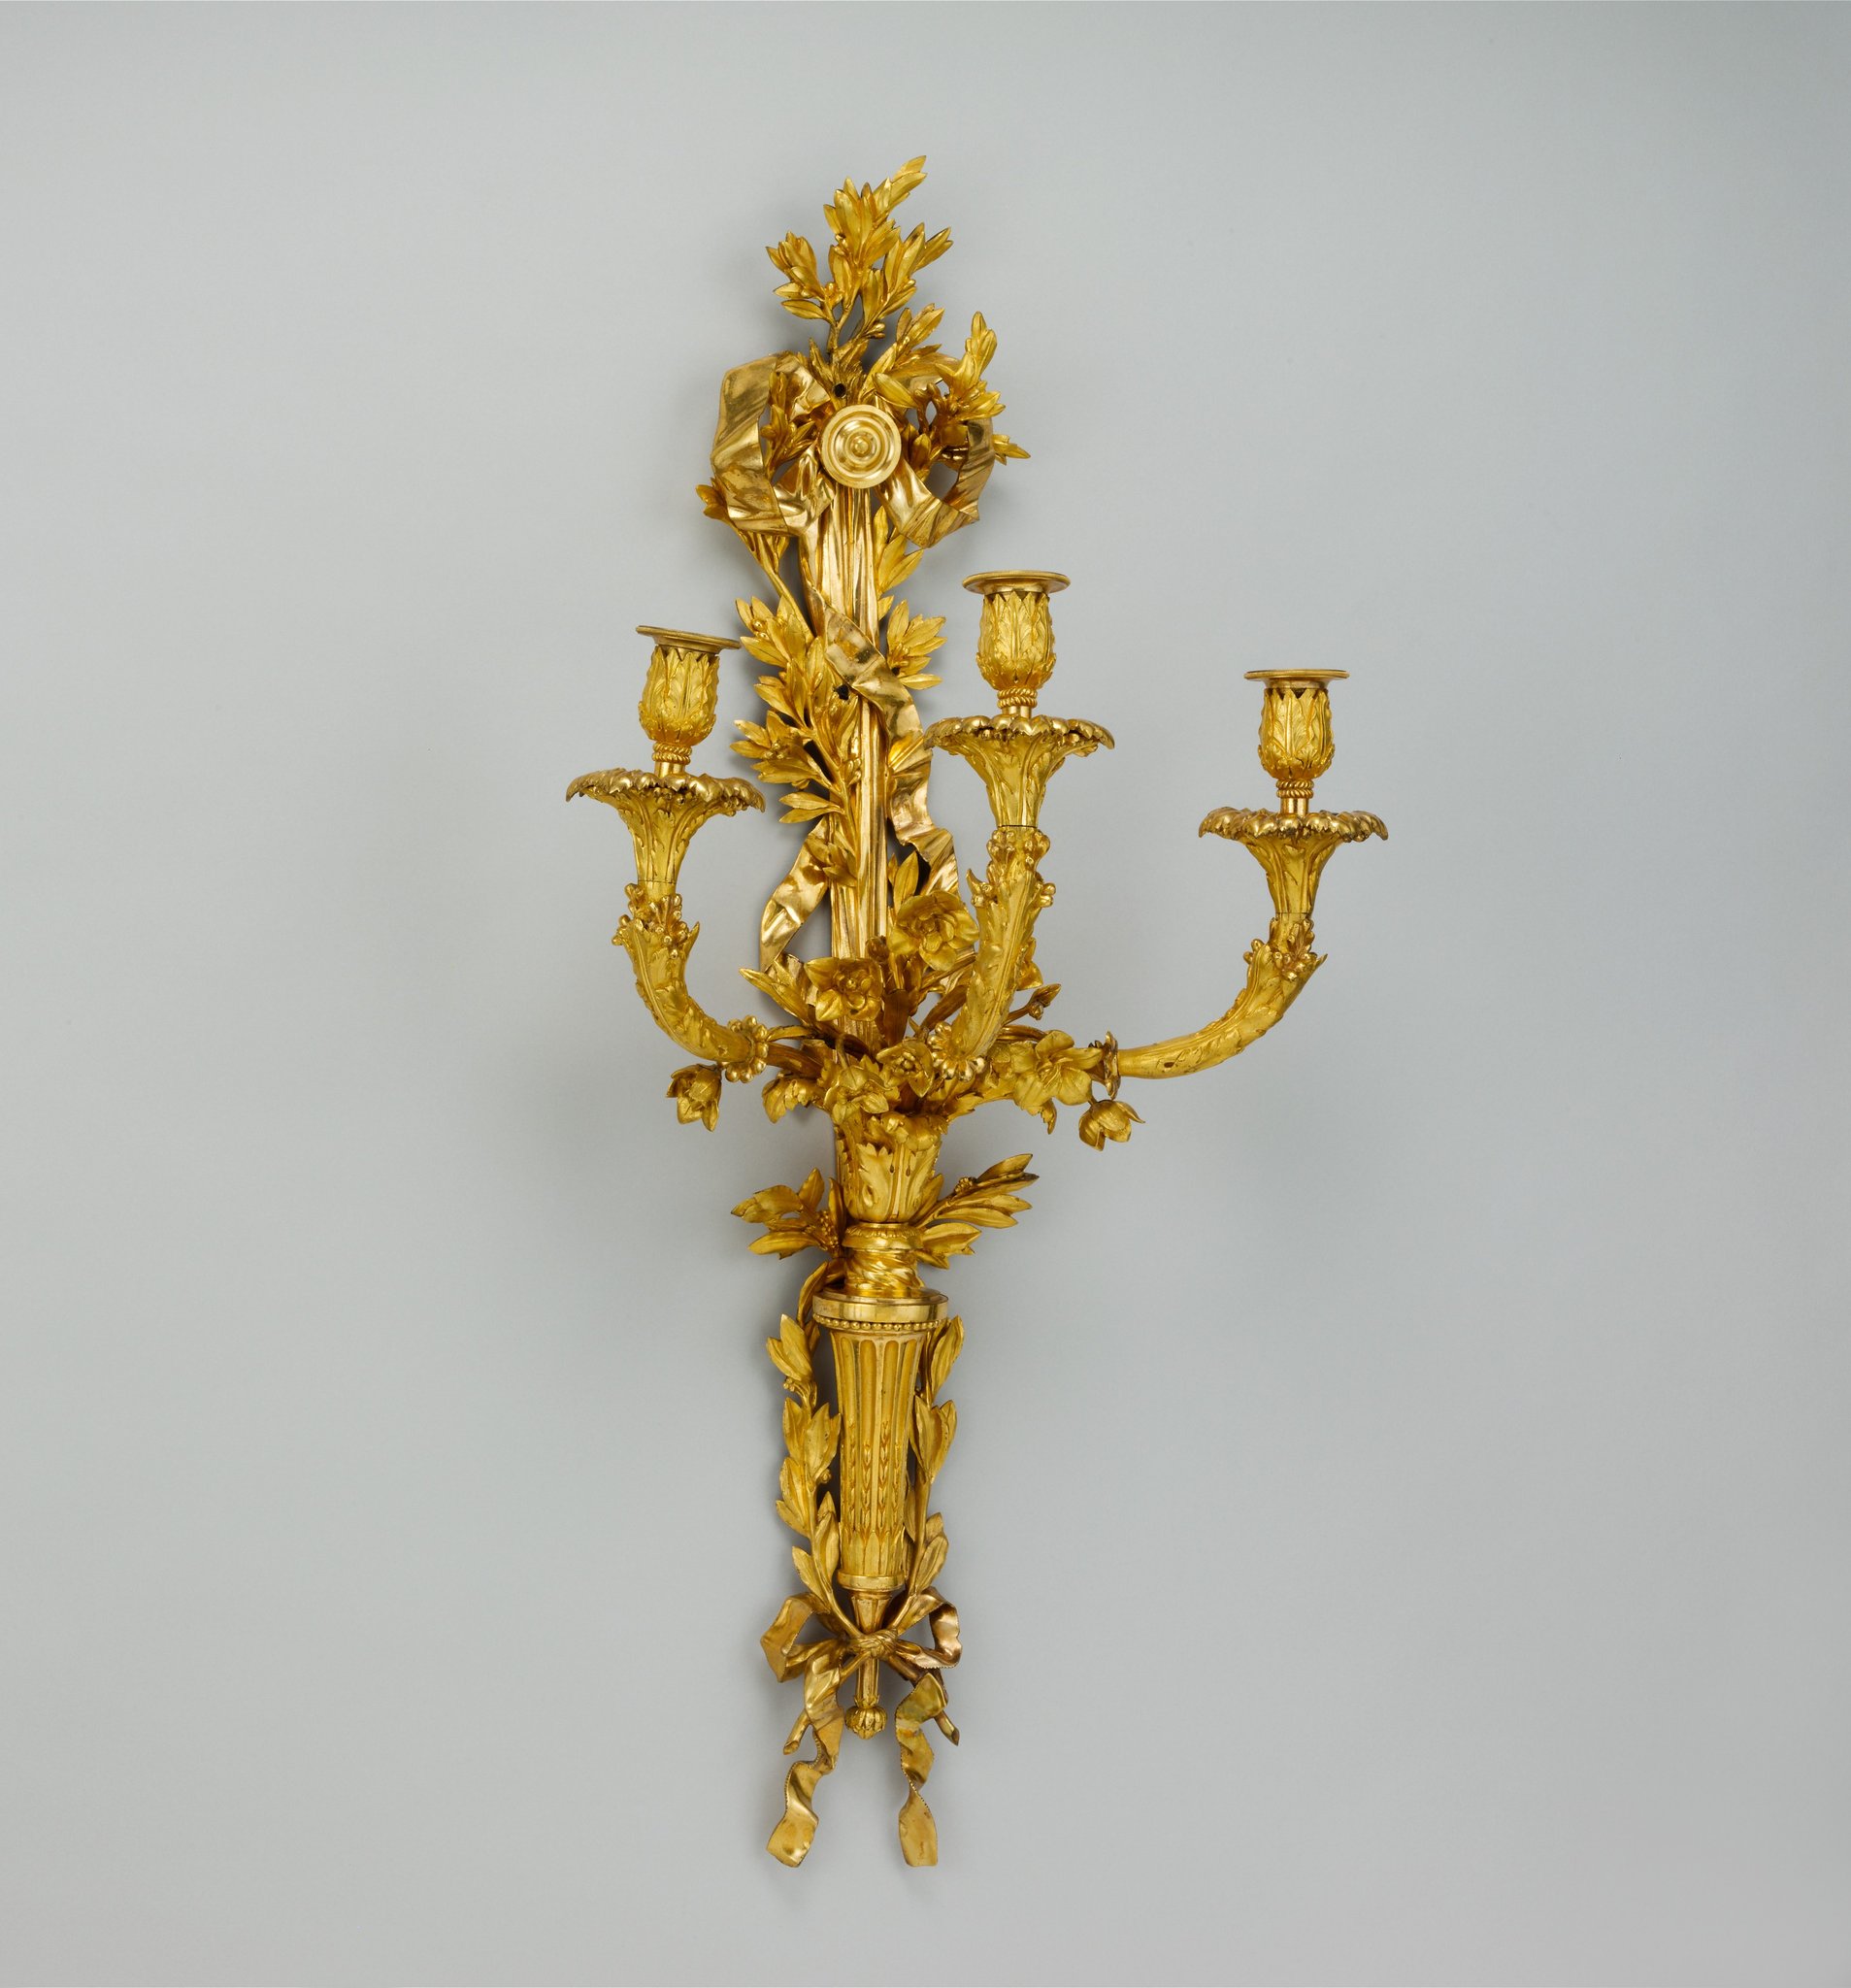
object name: wall bracket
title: Set of four three-light wall brackets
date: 1785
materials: gilt bronze